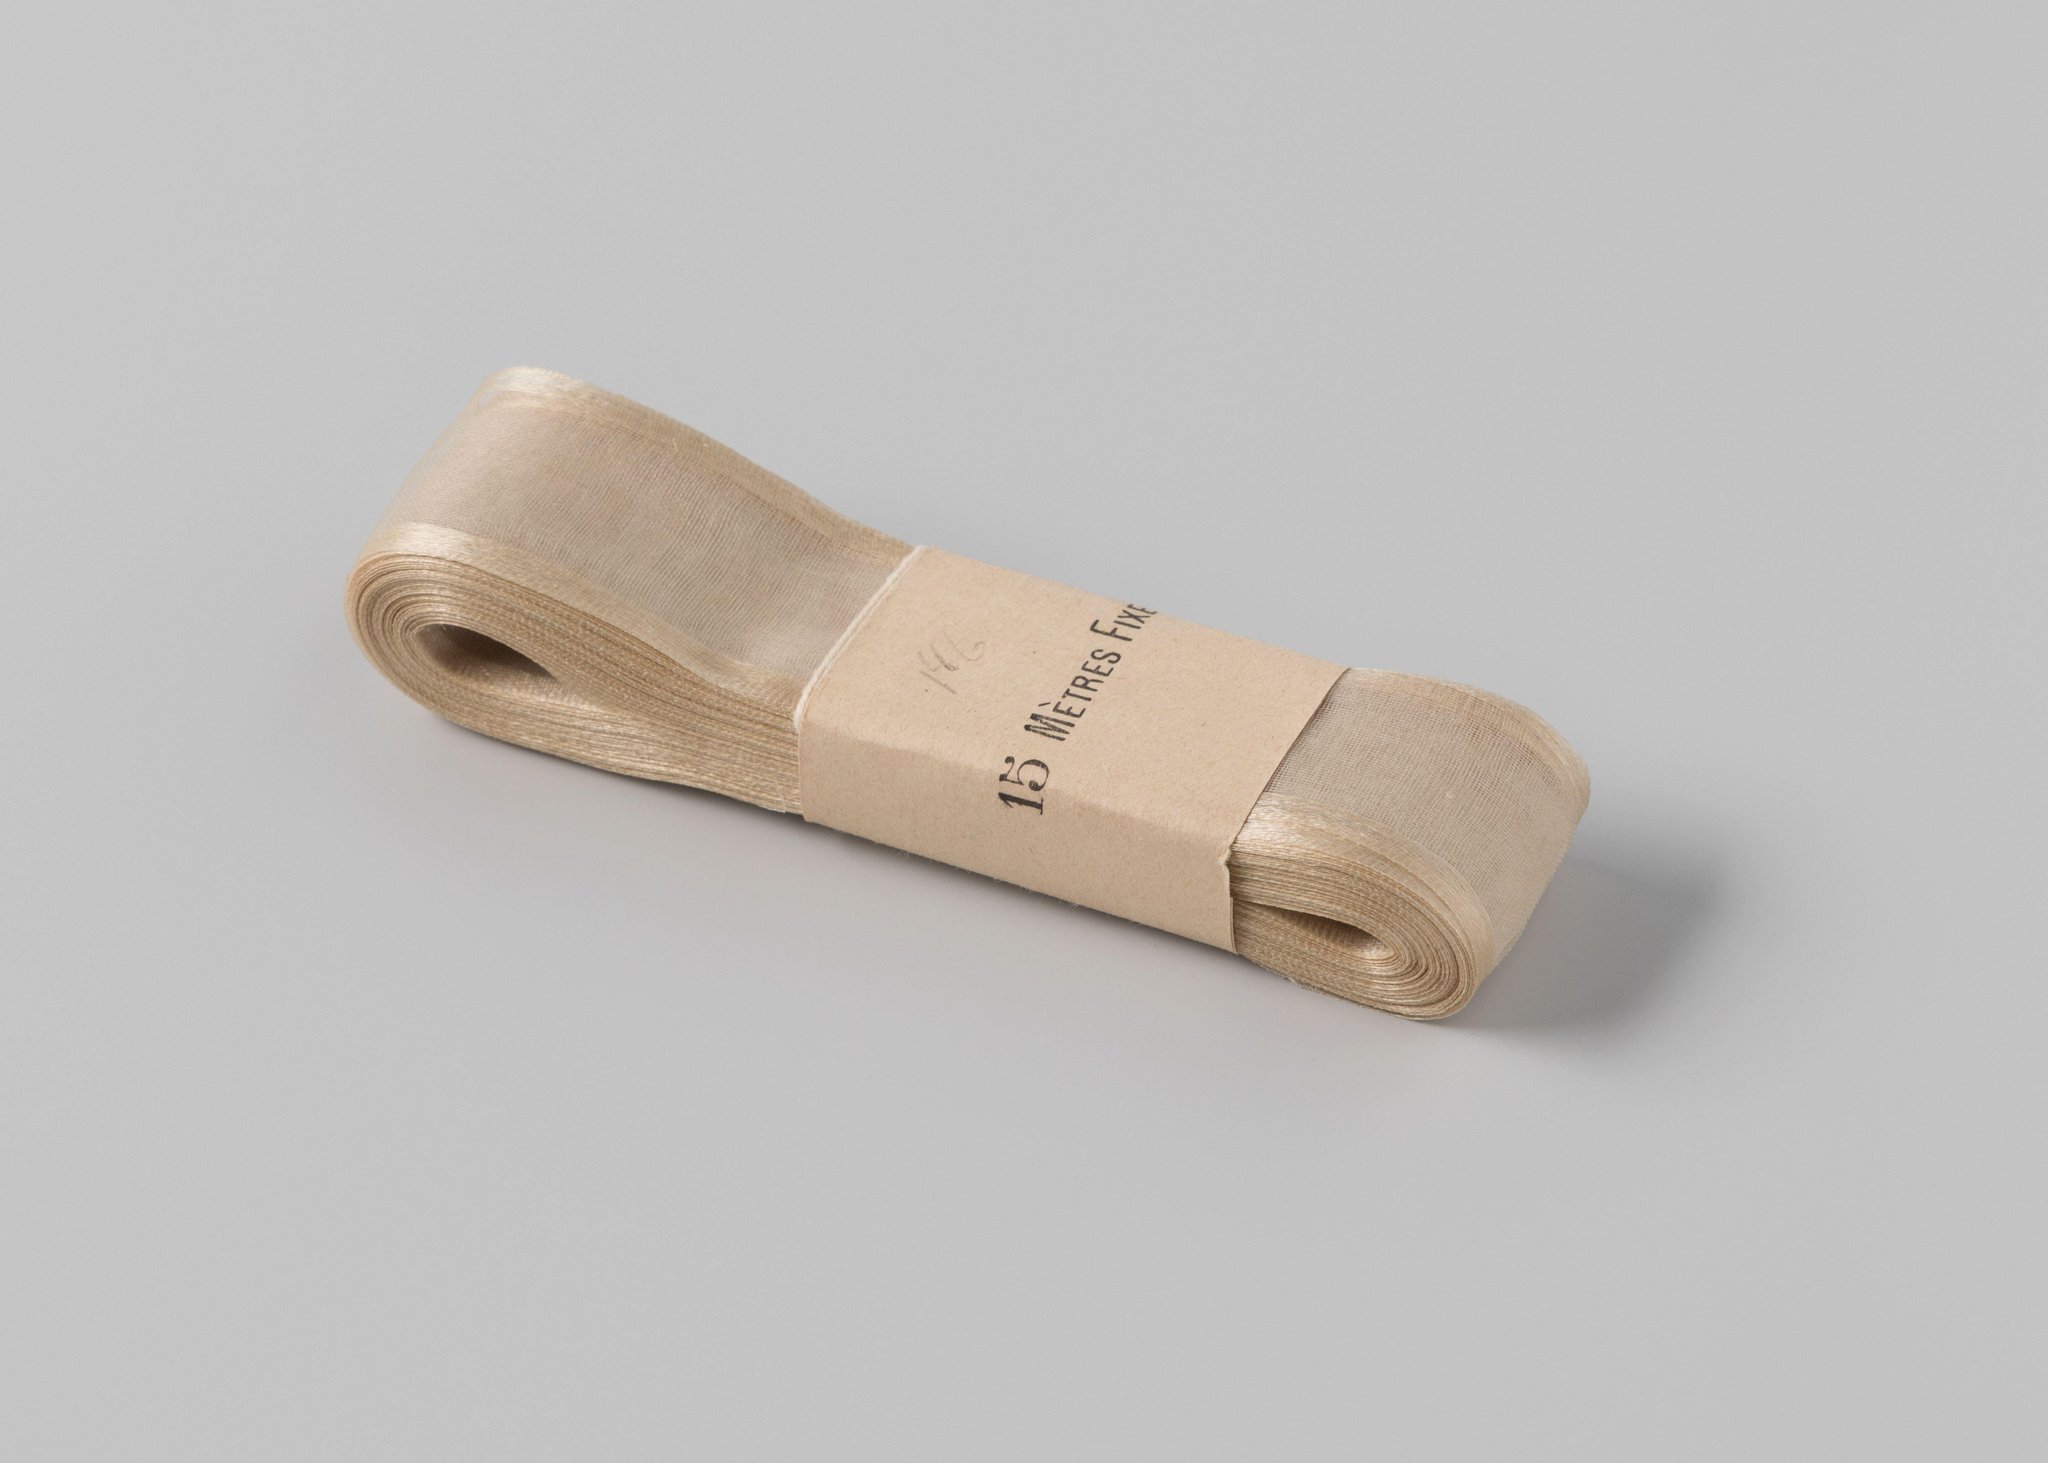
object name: ribbon material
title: Lint van crèmekleurig gaas van 15 meter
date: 1900-1915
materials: textile, silk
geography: nijmegen